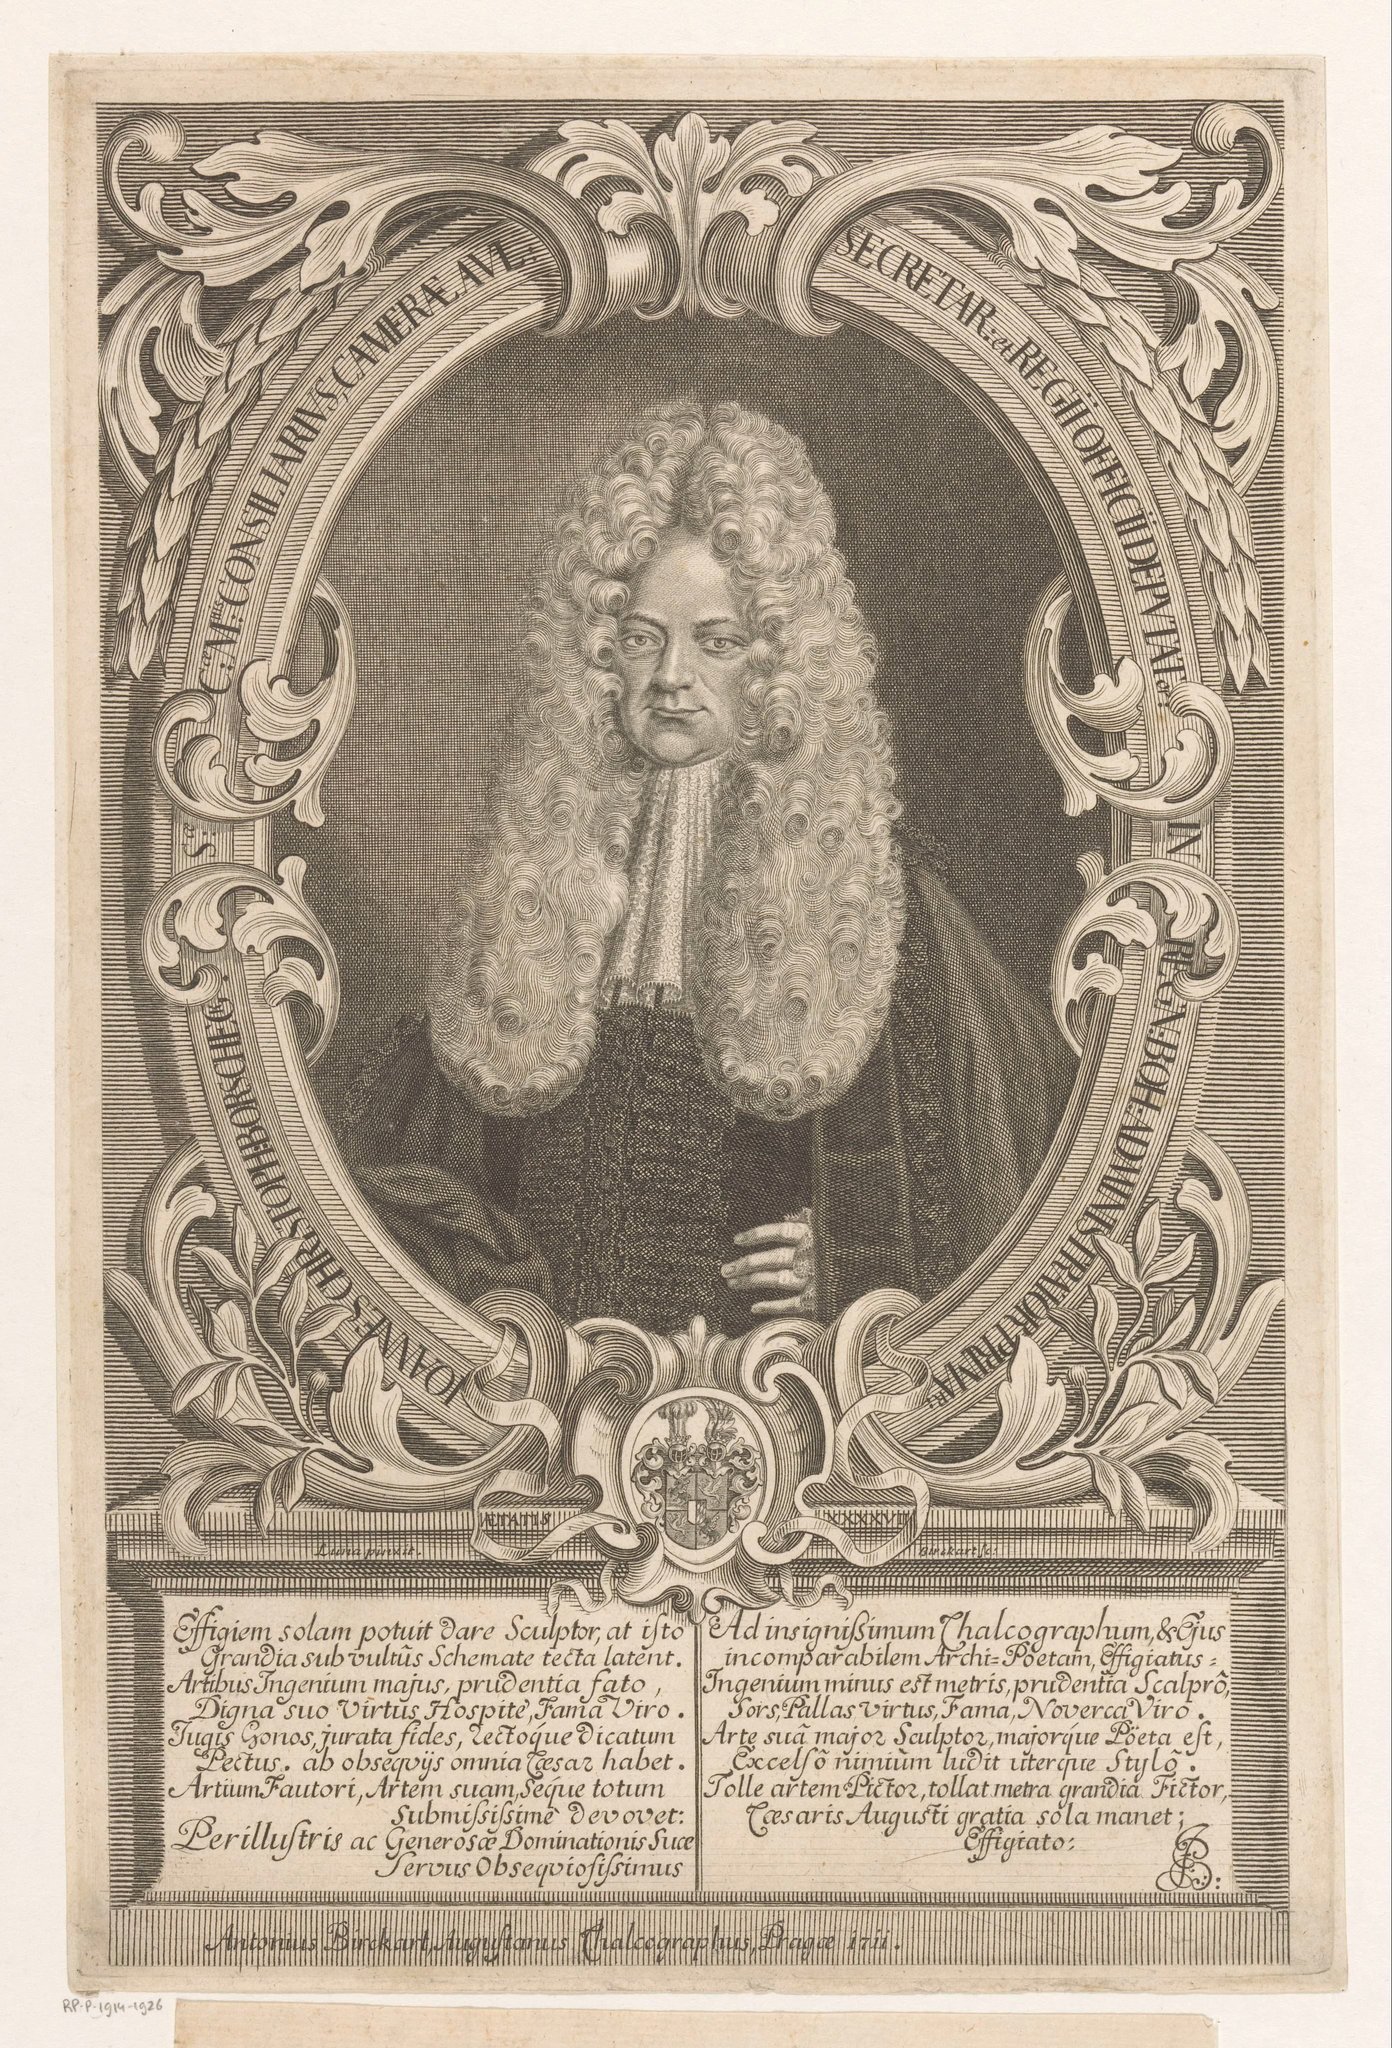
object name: print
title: Portret van Johann Christoph Borscheck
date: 1711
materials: paper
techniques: engraving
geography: prague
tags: historical persons, armorial bearing, heraldry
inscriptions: collector's mark: Lugt 2228